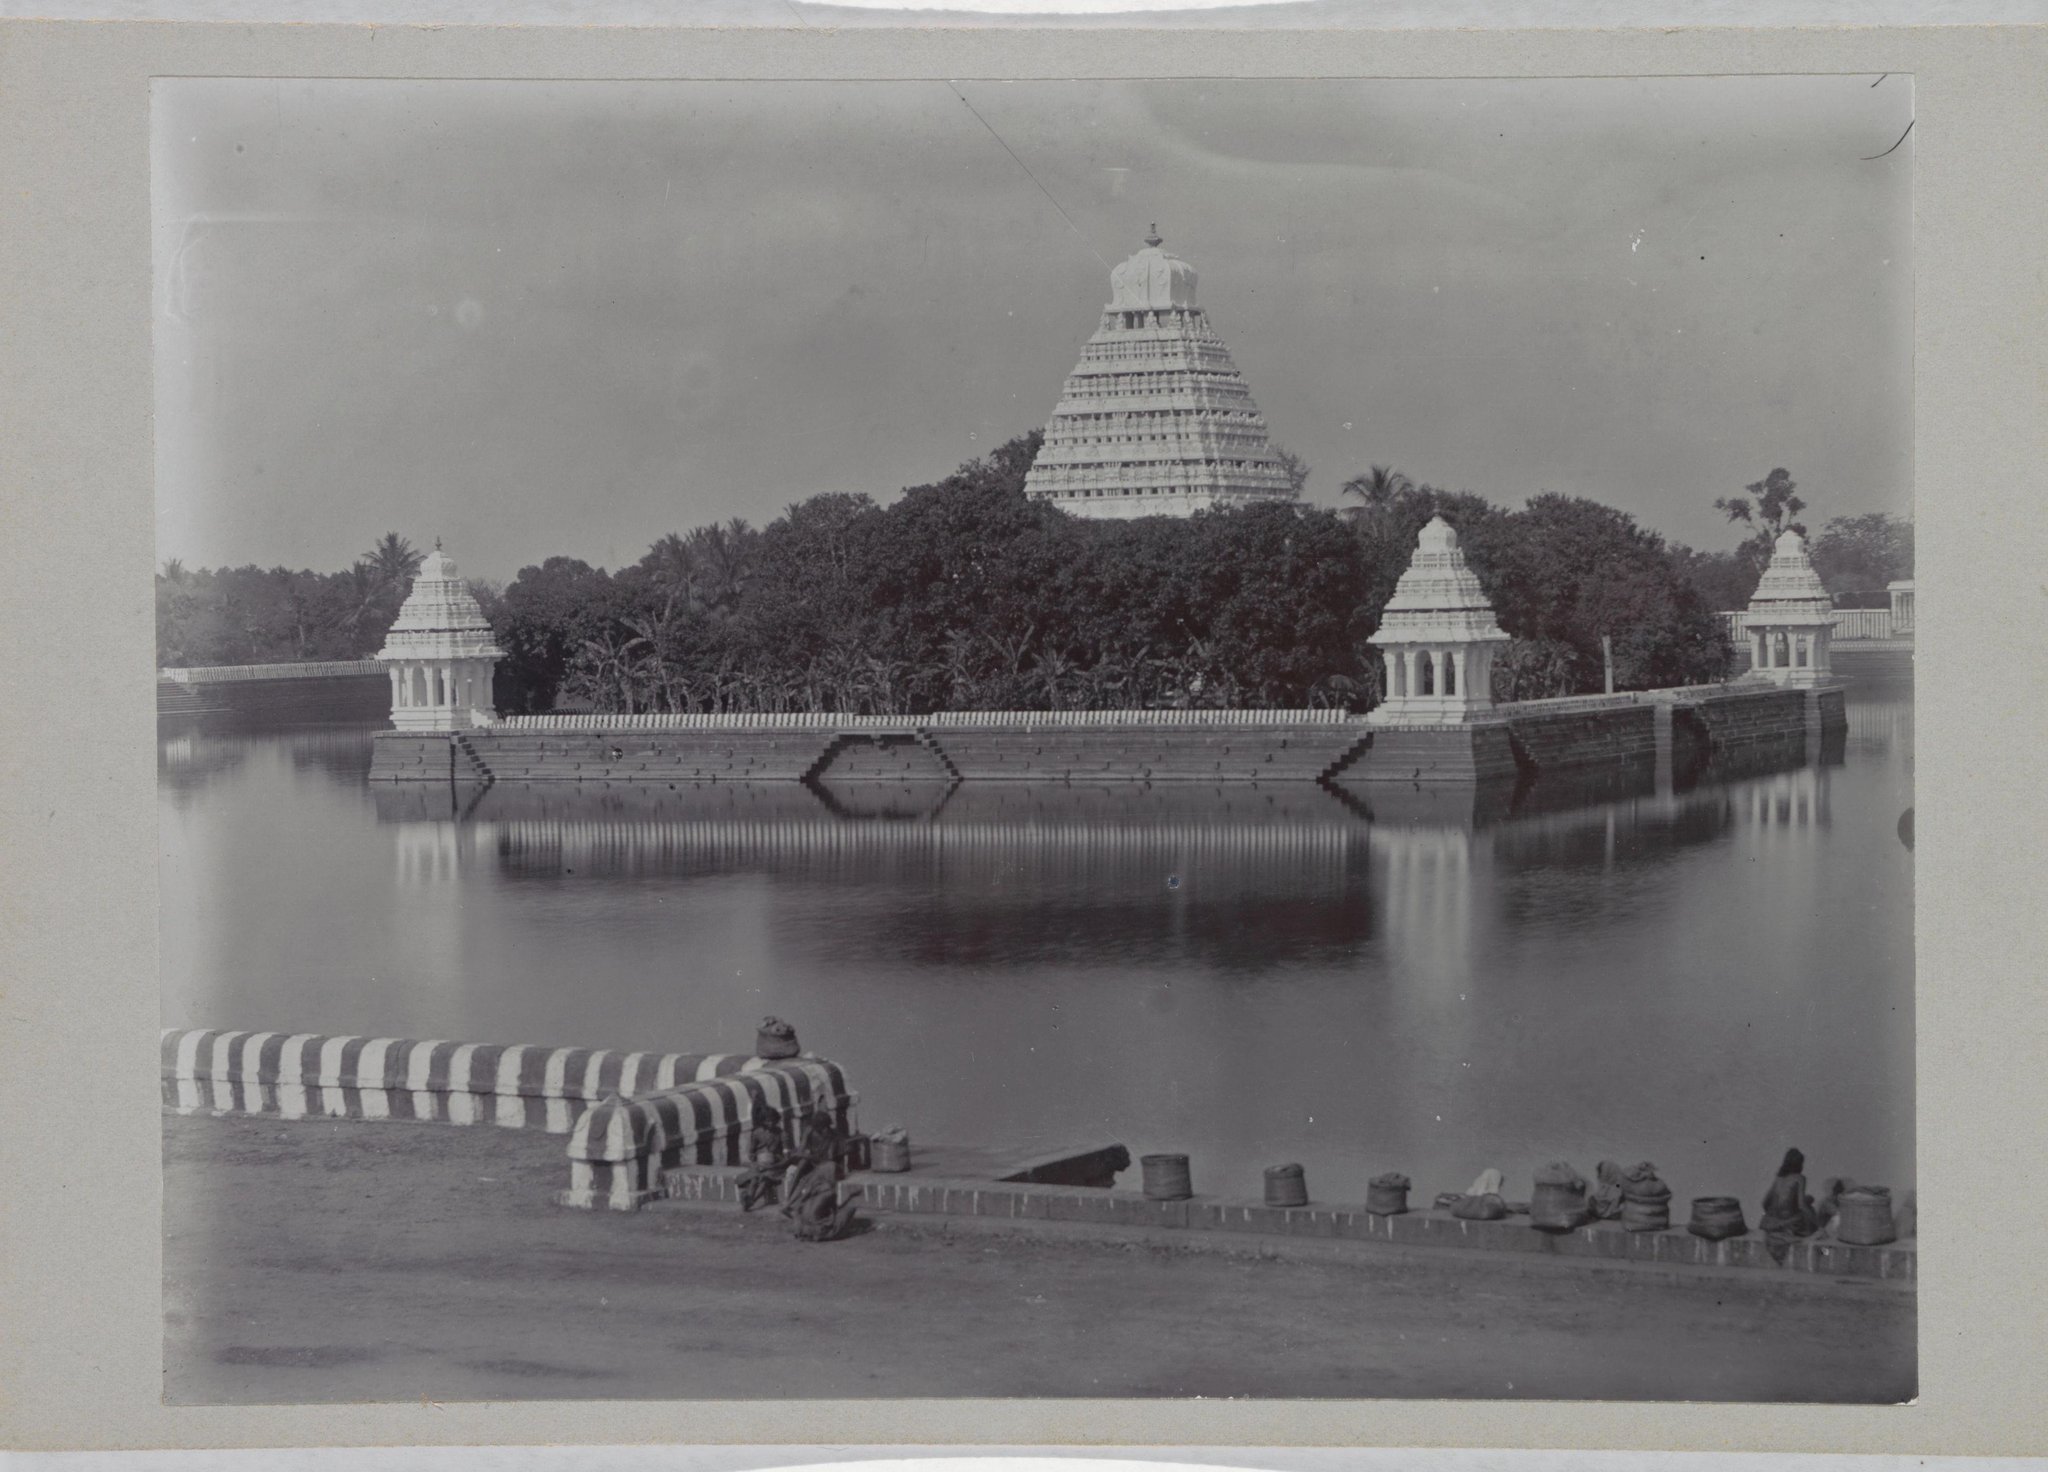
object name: photograph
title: Vandiyur Mariamman Teppakulam at Madurai, Tamil Nadu, India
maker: Anonymous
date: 1895-1915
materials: cardboard, paper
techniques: gelatin silver print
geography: madurai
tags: madurai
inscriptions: annotation: ‘78 Teppa-Kulan bij Madura.’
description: Waterreservoir met in het midden een mandapam. Vandiyur Mariamman Teppakulam is een tempeltank in de buurt van de Vandiyur Mariamman-tempel en op een afstand van ongeveer 5 km van de Minakshitempel.